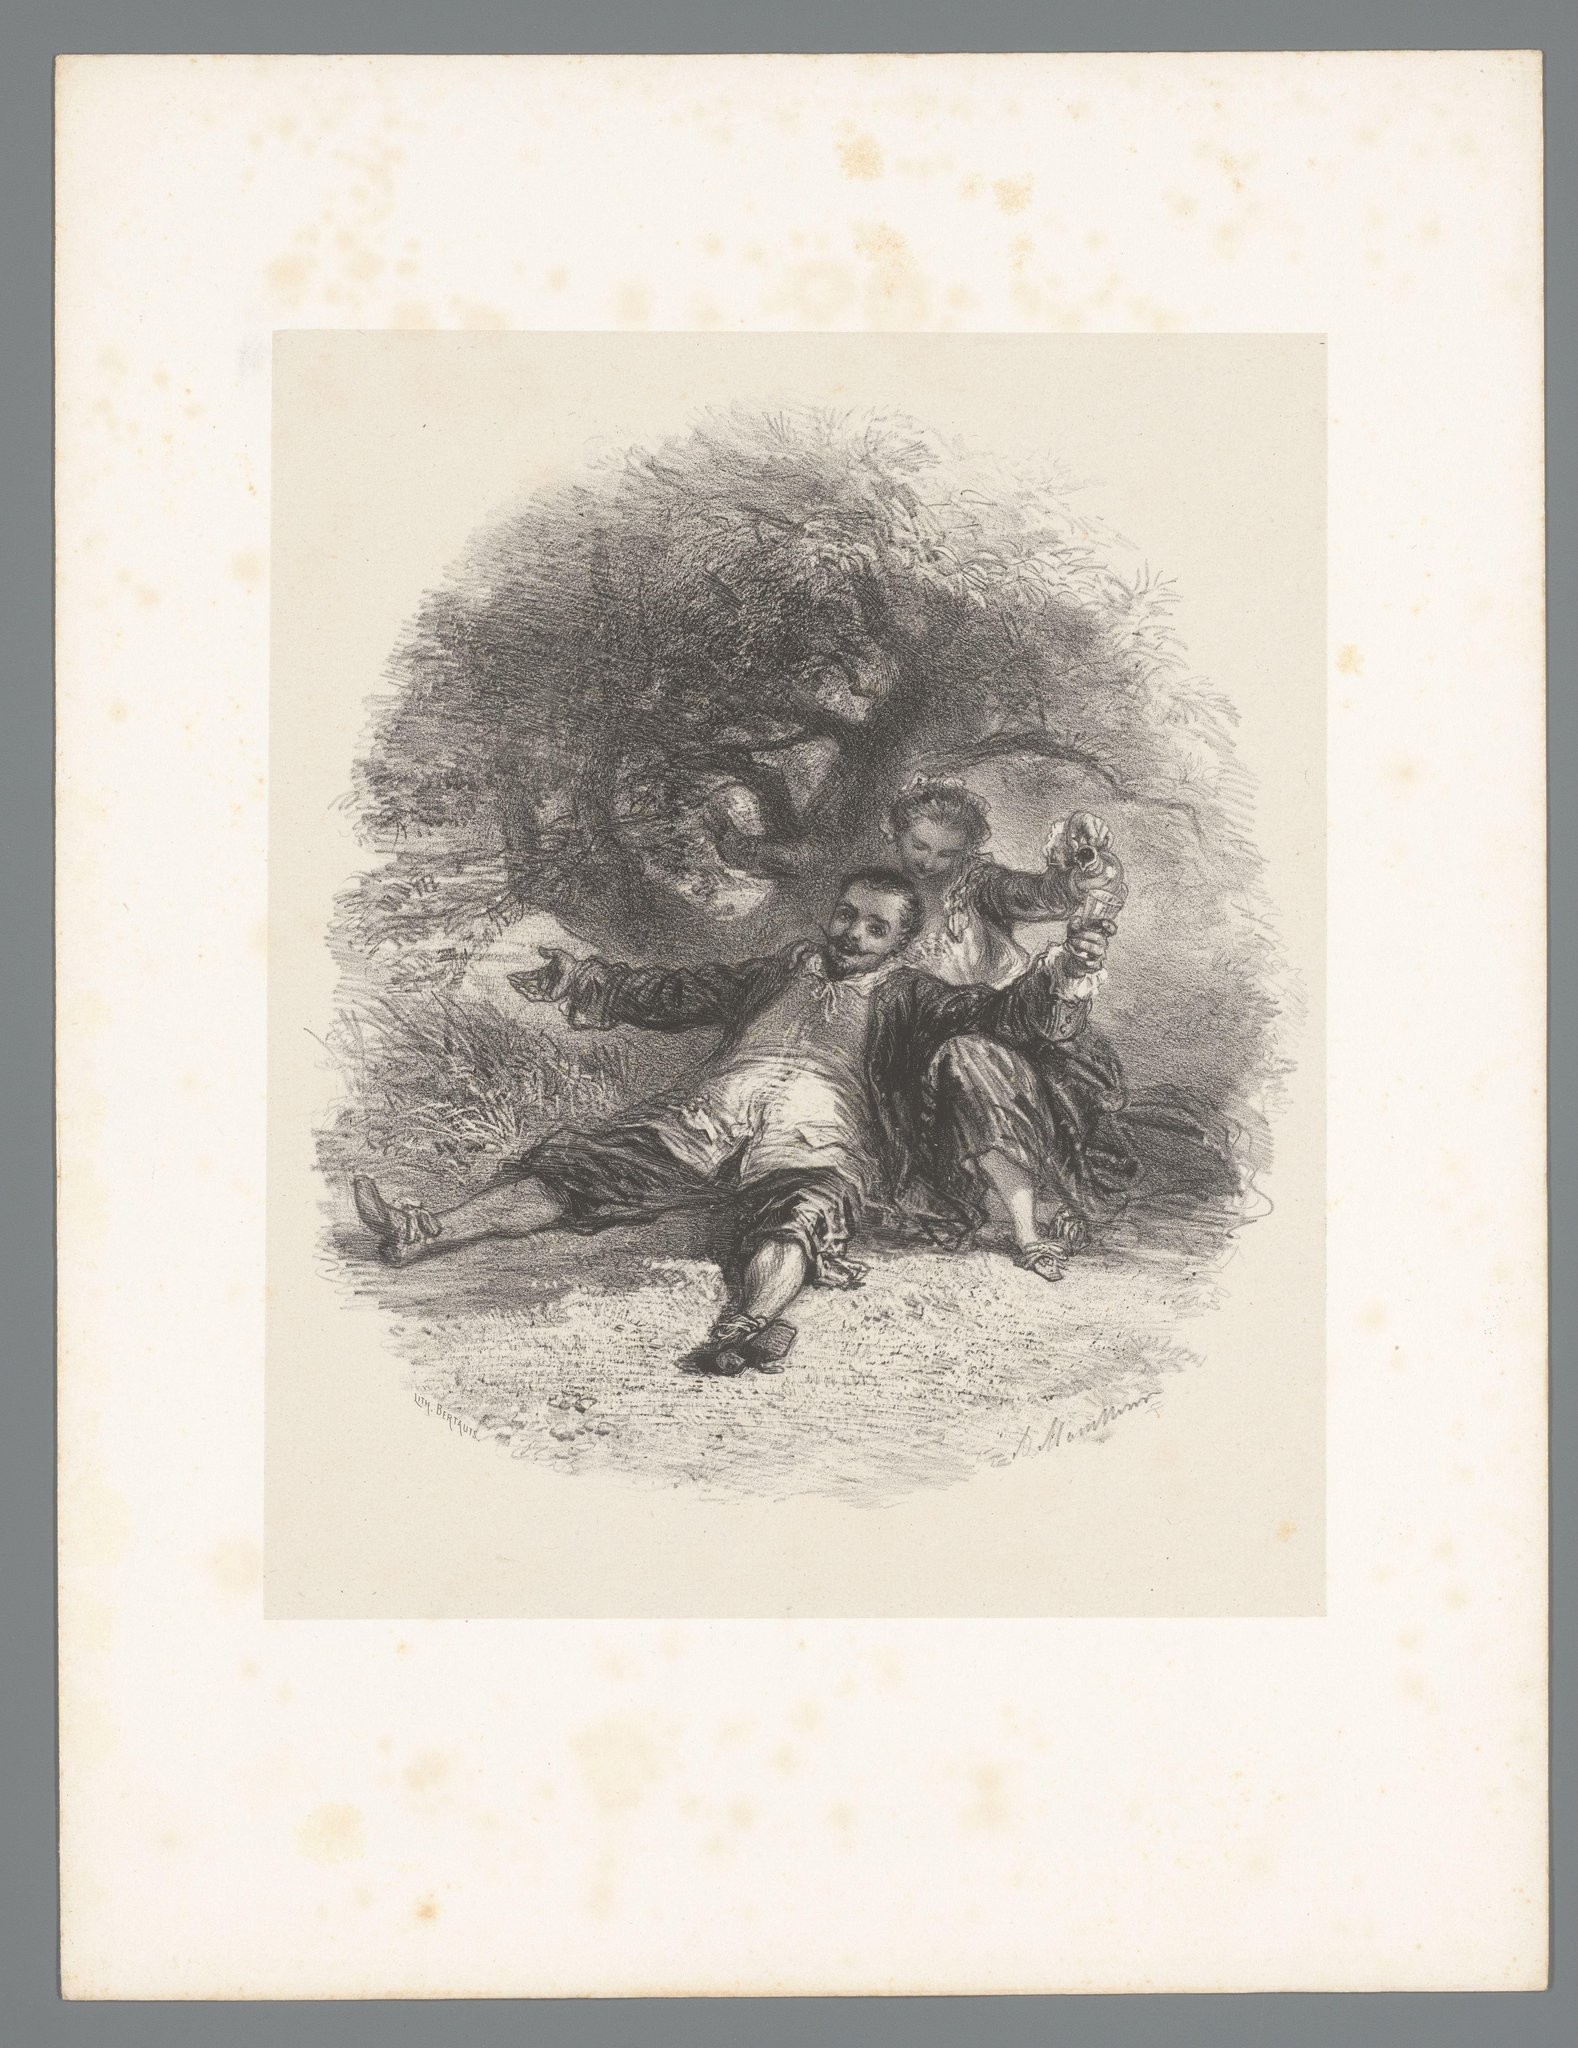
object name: print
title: Man en vrouw drinkend onder een boom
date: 1830-1880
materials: paper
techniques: lithograph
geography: paris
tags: couple of lovers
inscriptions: collector's mark: Lugt 964